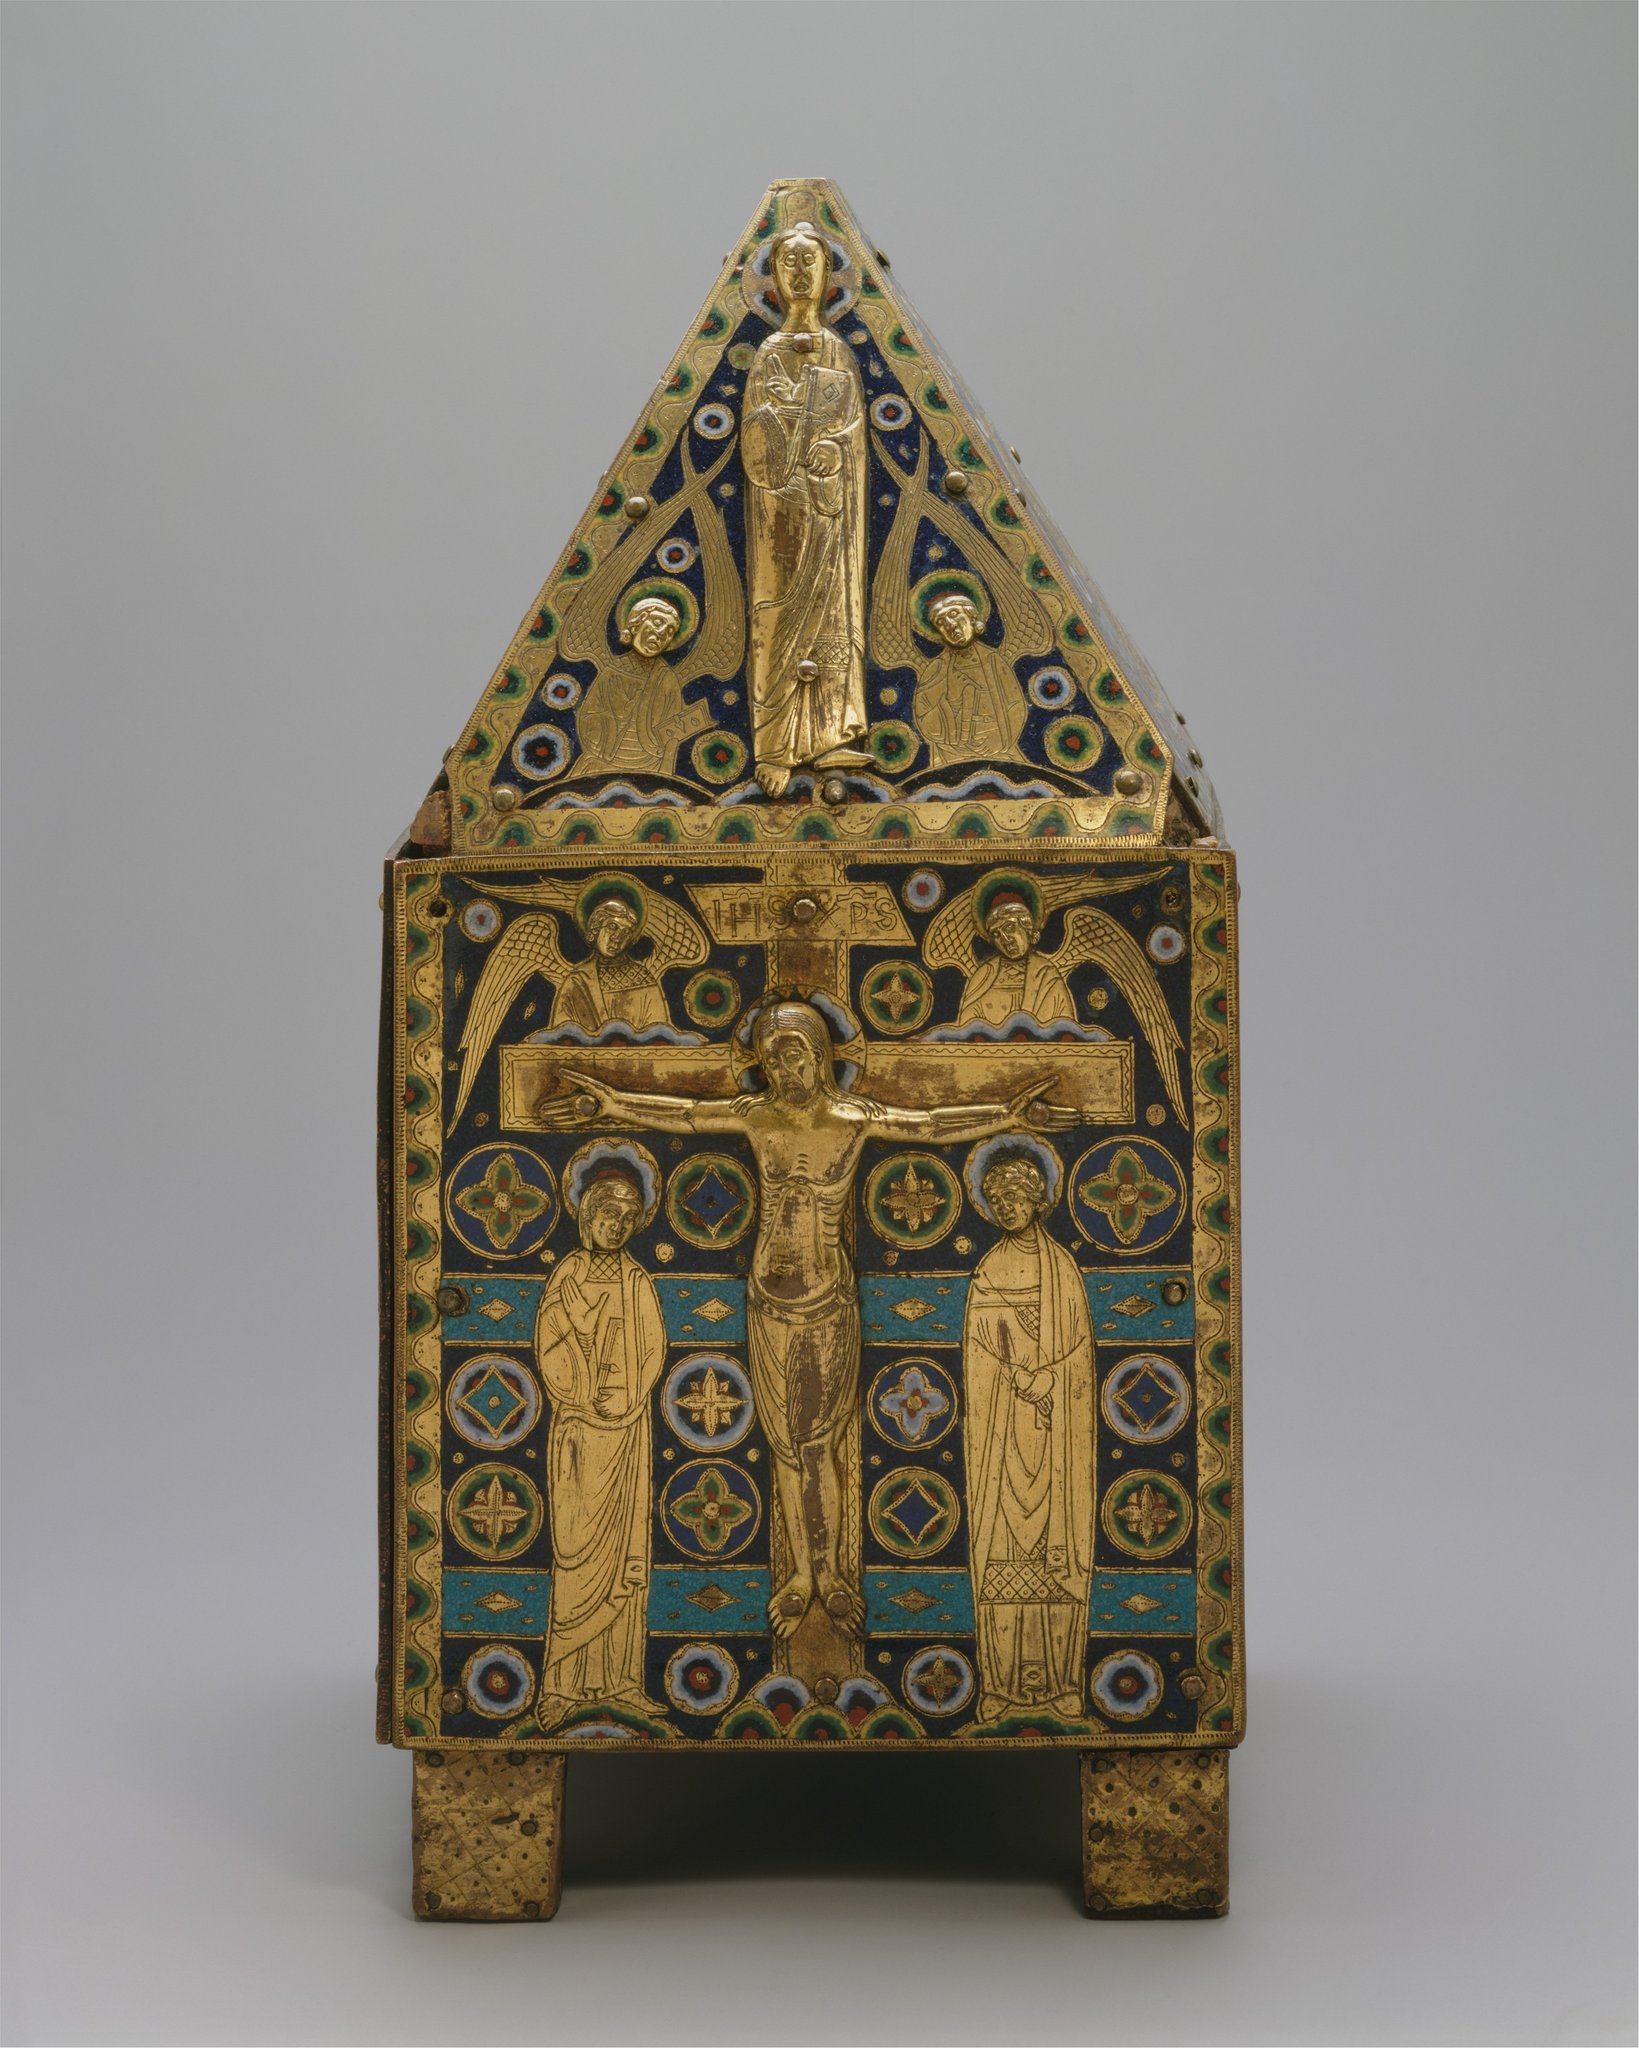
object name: tabernacle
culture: french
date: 1200-1210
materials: copper, enamel, gilt, wood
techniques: enamel, chasing, engraving, painting, repoussé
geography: france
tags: angels,christ,saints